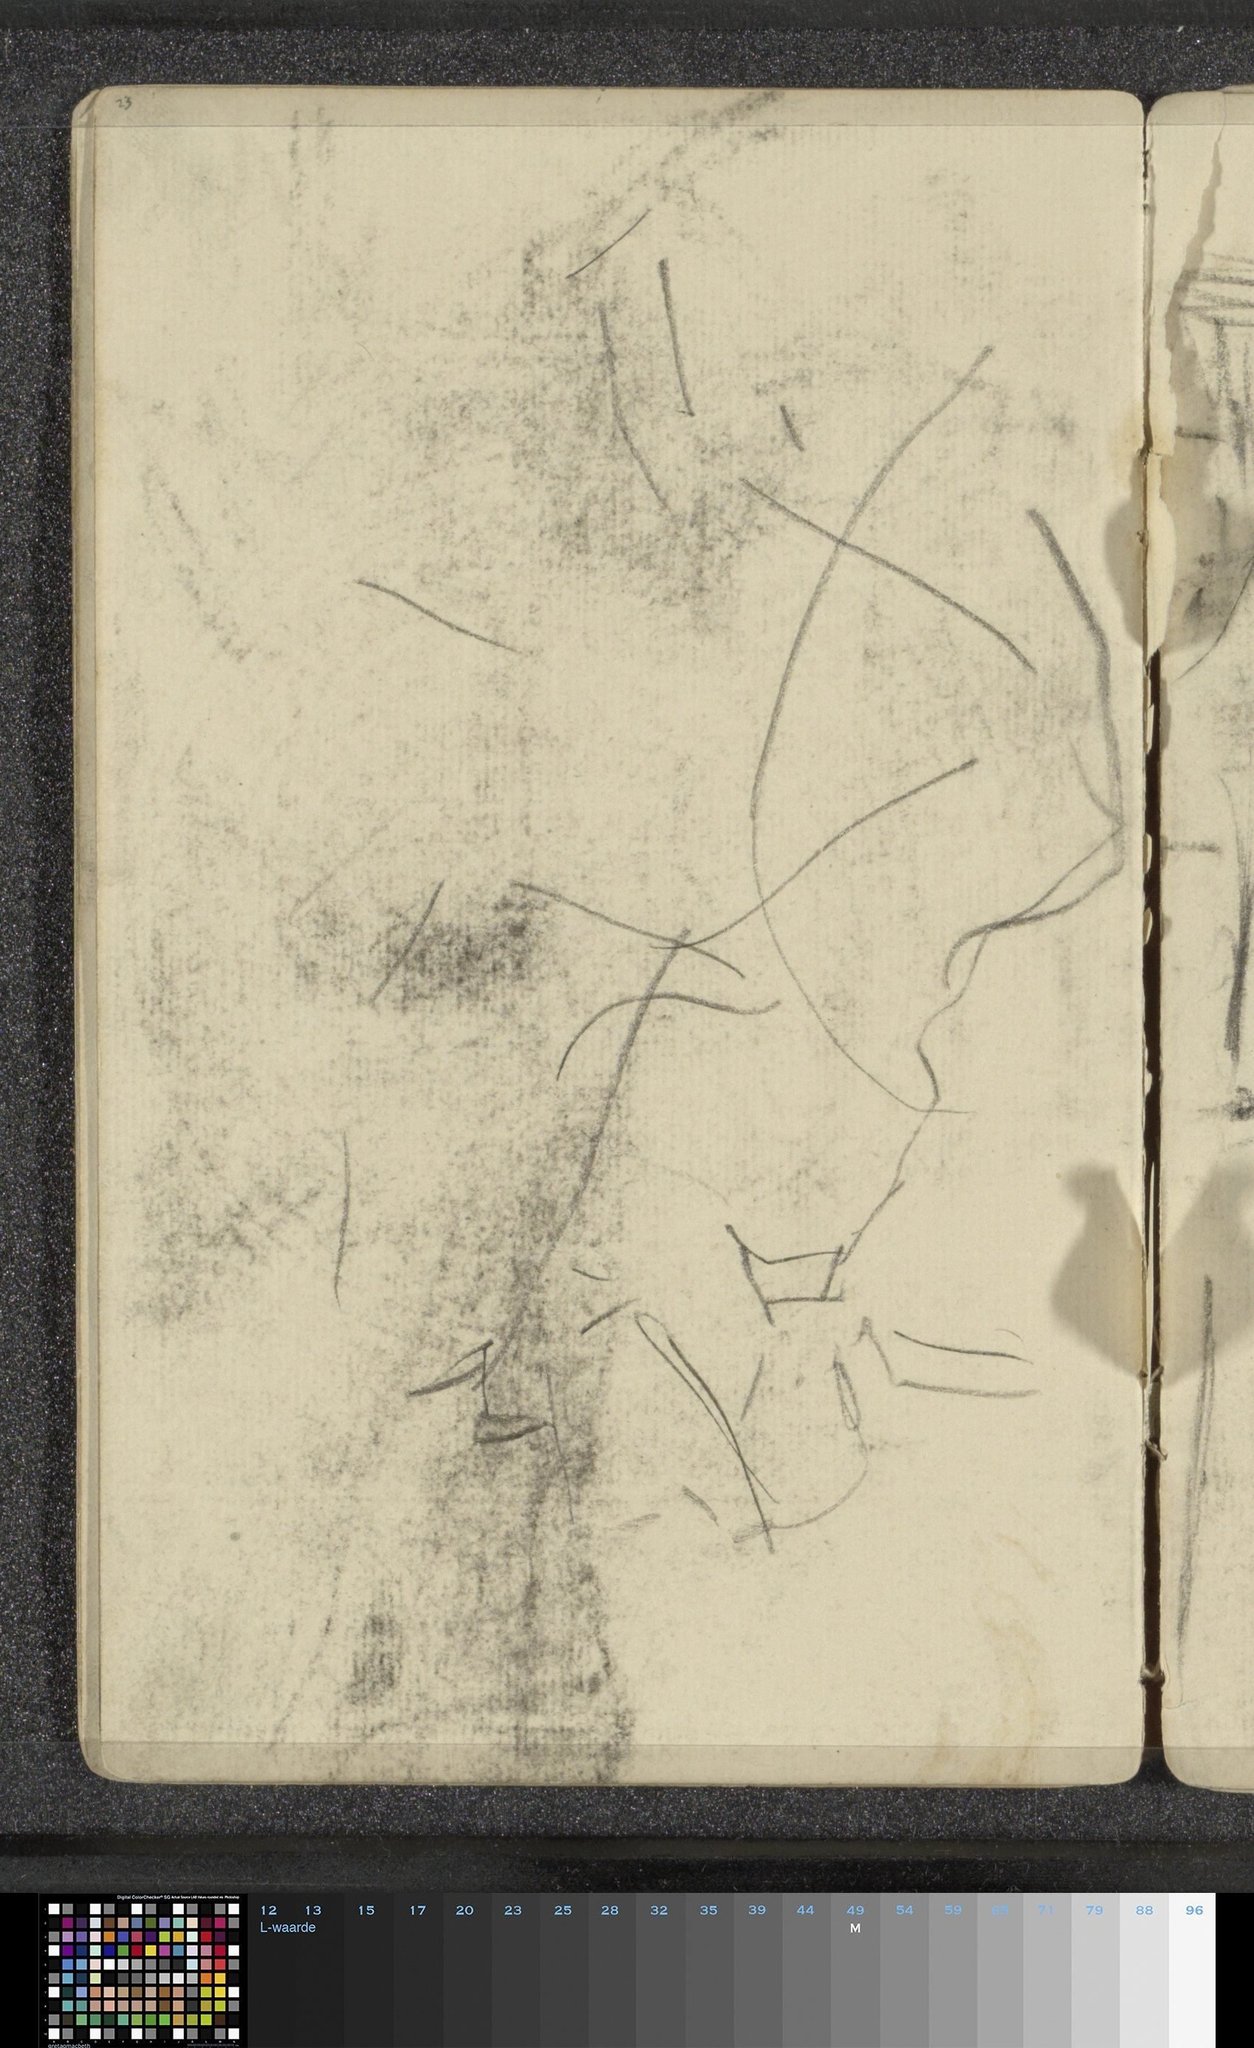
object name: sketchbook leaf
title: Studie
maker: george hendrik breitner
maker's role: draughtsman, painter, print maker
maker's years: 1857-1923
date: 1880-1882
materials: chalk, paper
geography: the hague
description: Pagina 23 uit een schetsboek met 19 bladen.